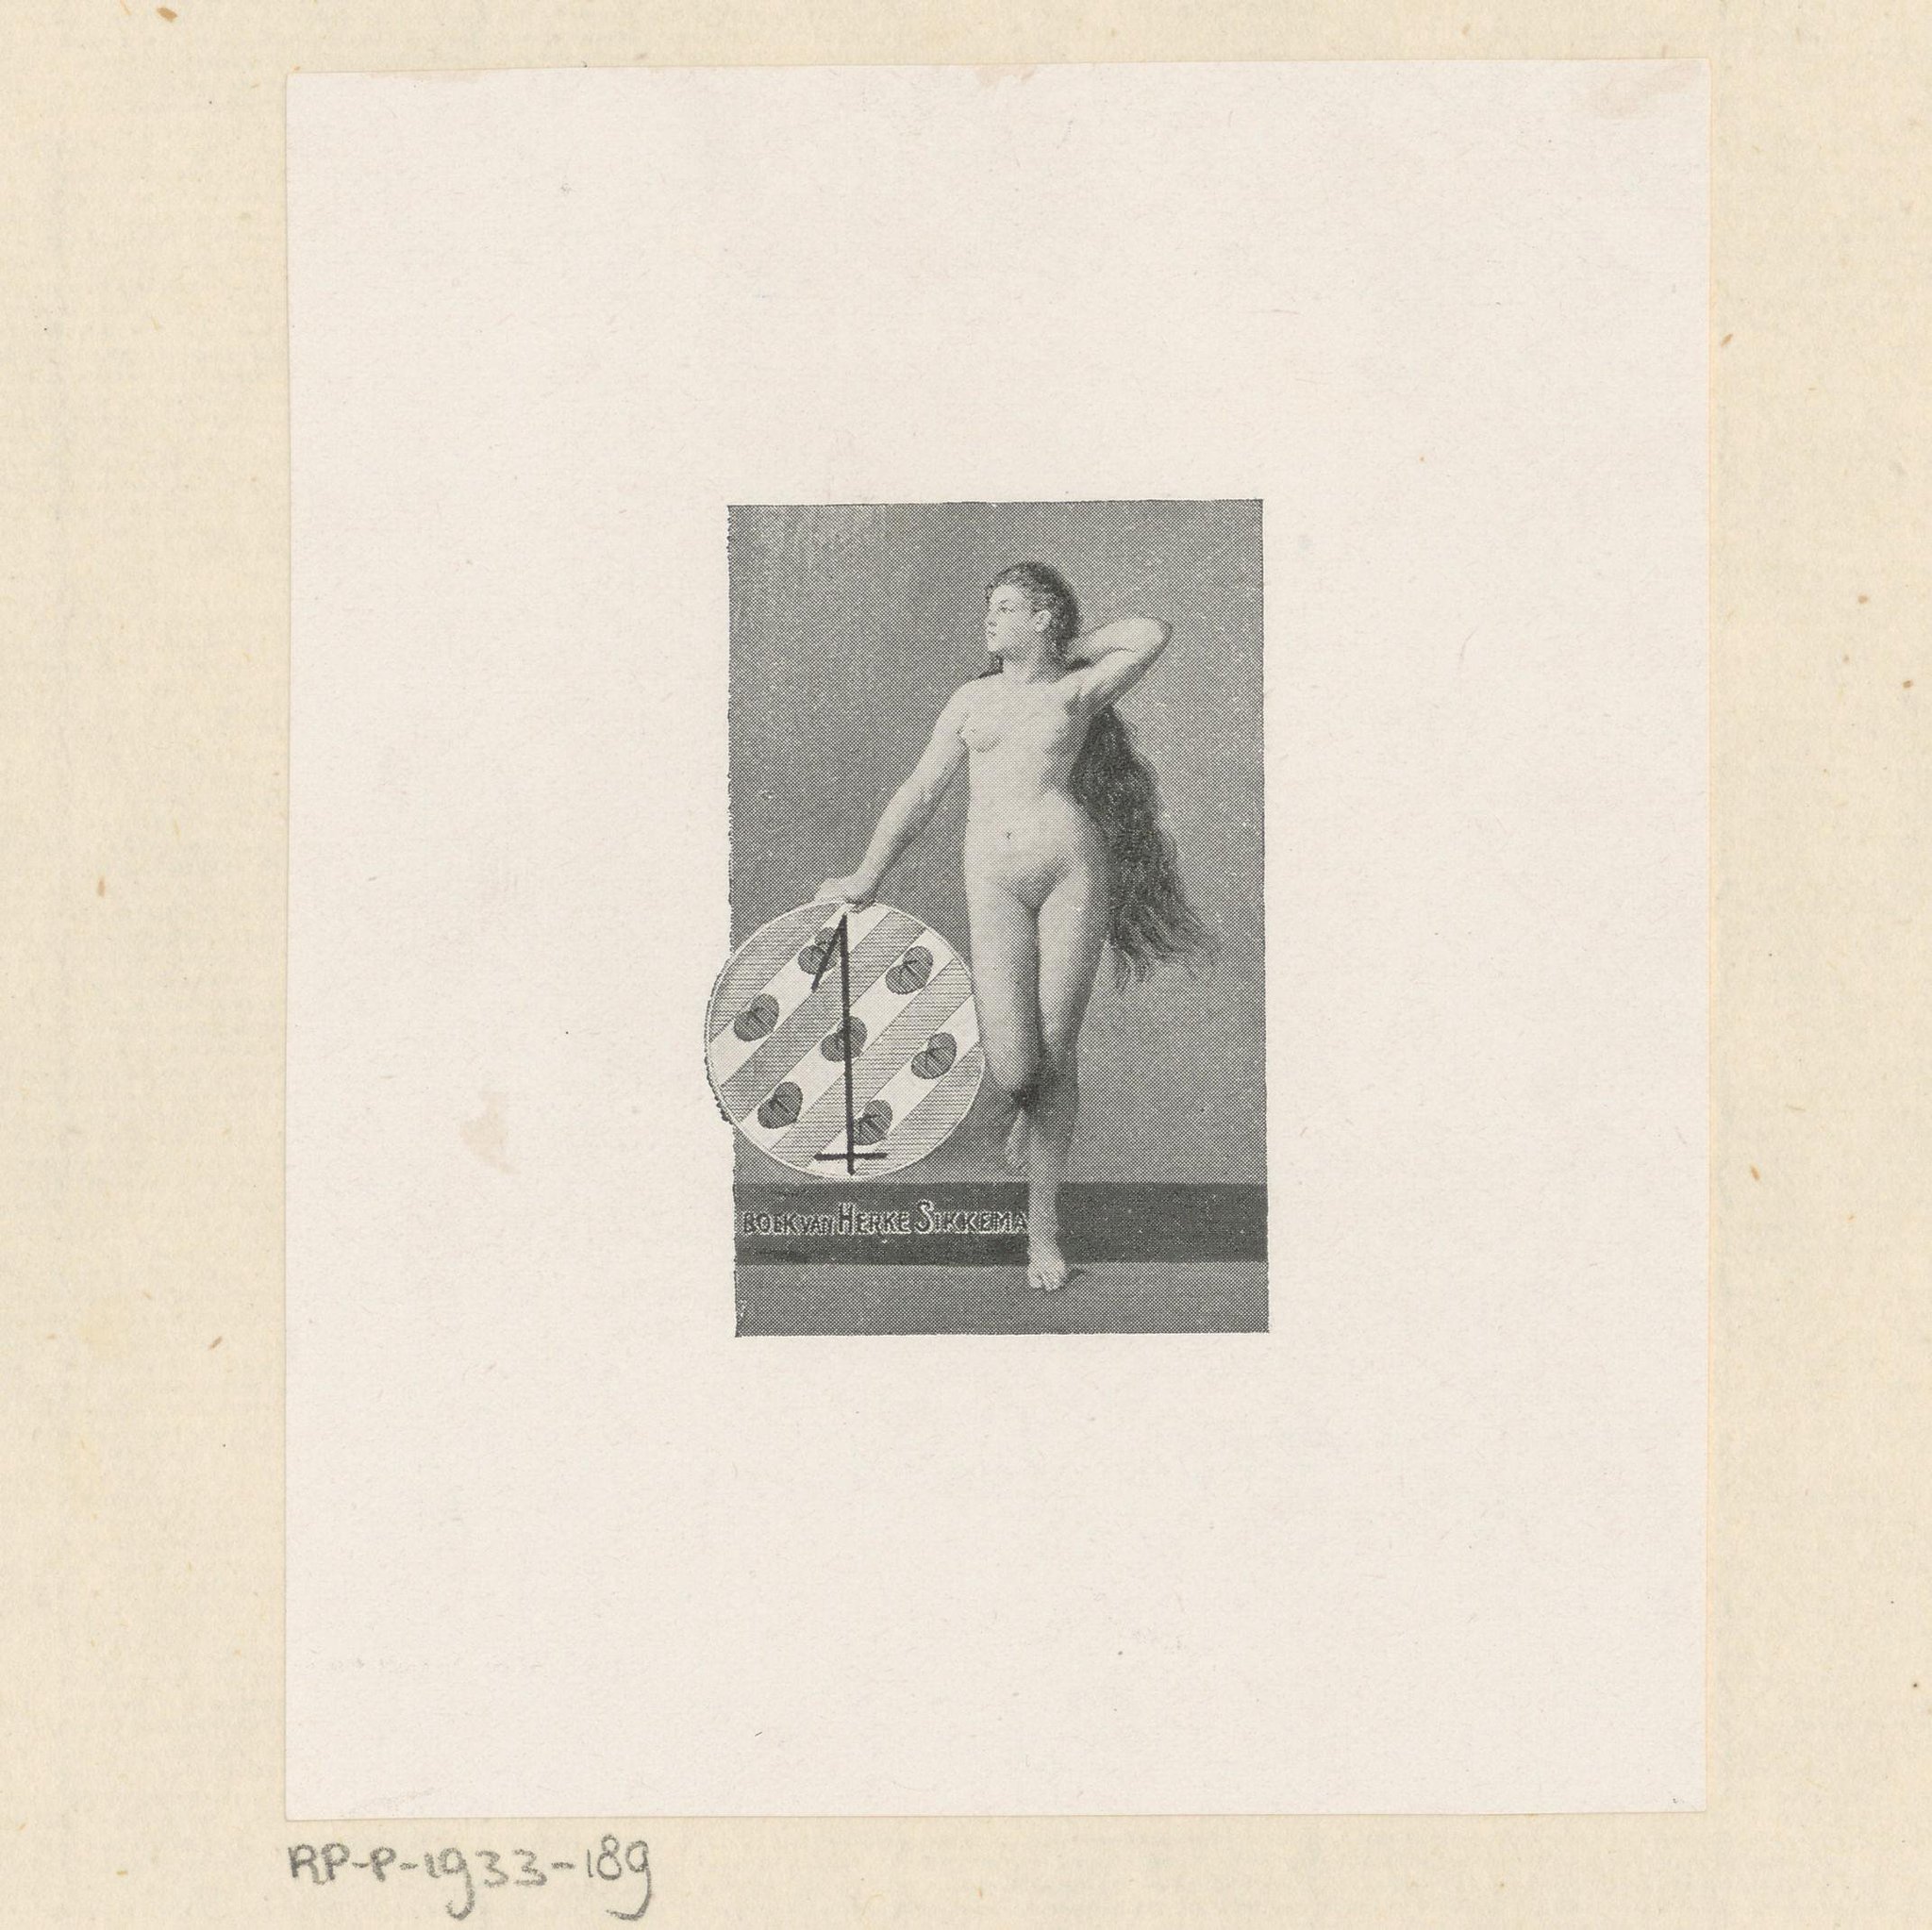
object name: bookplate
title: Ex libris van Herke Sikkema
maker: Anonymous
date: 1880-1933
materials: paper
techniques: autotype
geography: netherlands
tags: woman (showing herself) undressed, quasi-nude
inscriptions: collector's mark: Lugt 2760